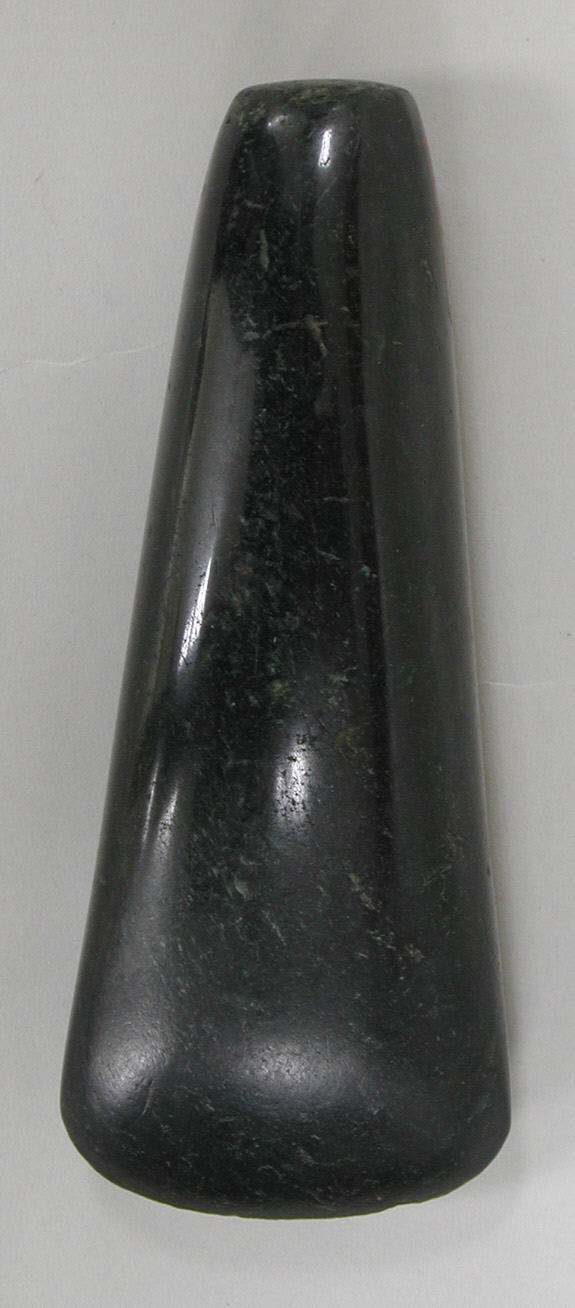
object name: celt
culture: maya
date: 1501-1600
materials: stone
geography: guatemala